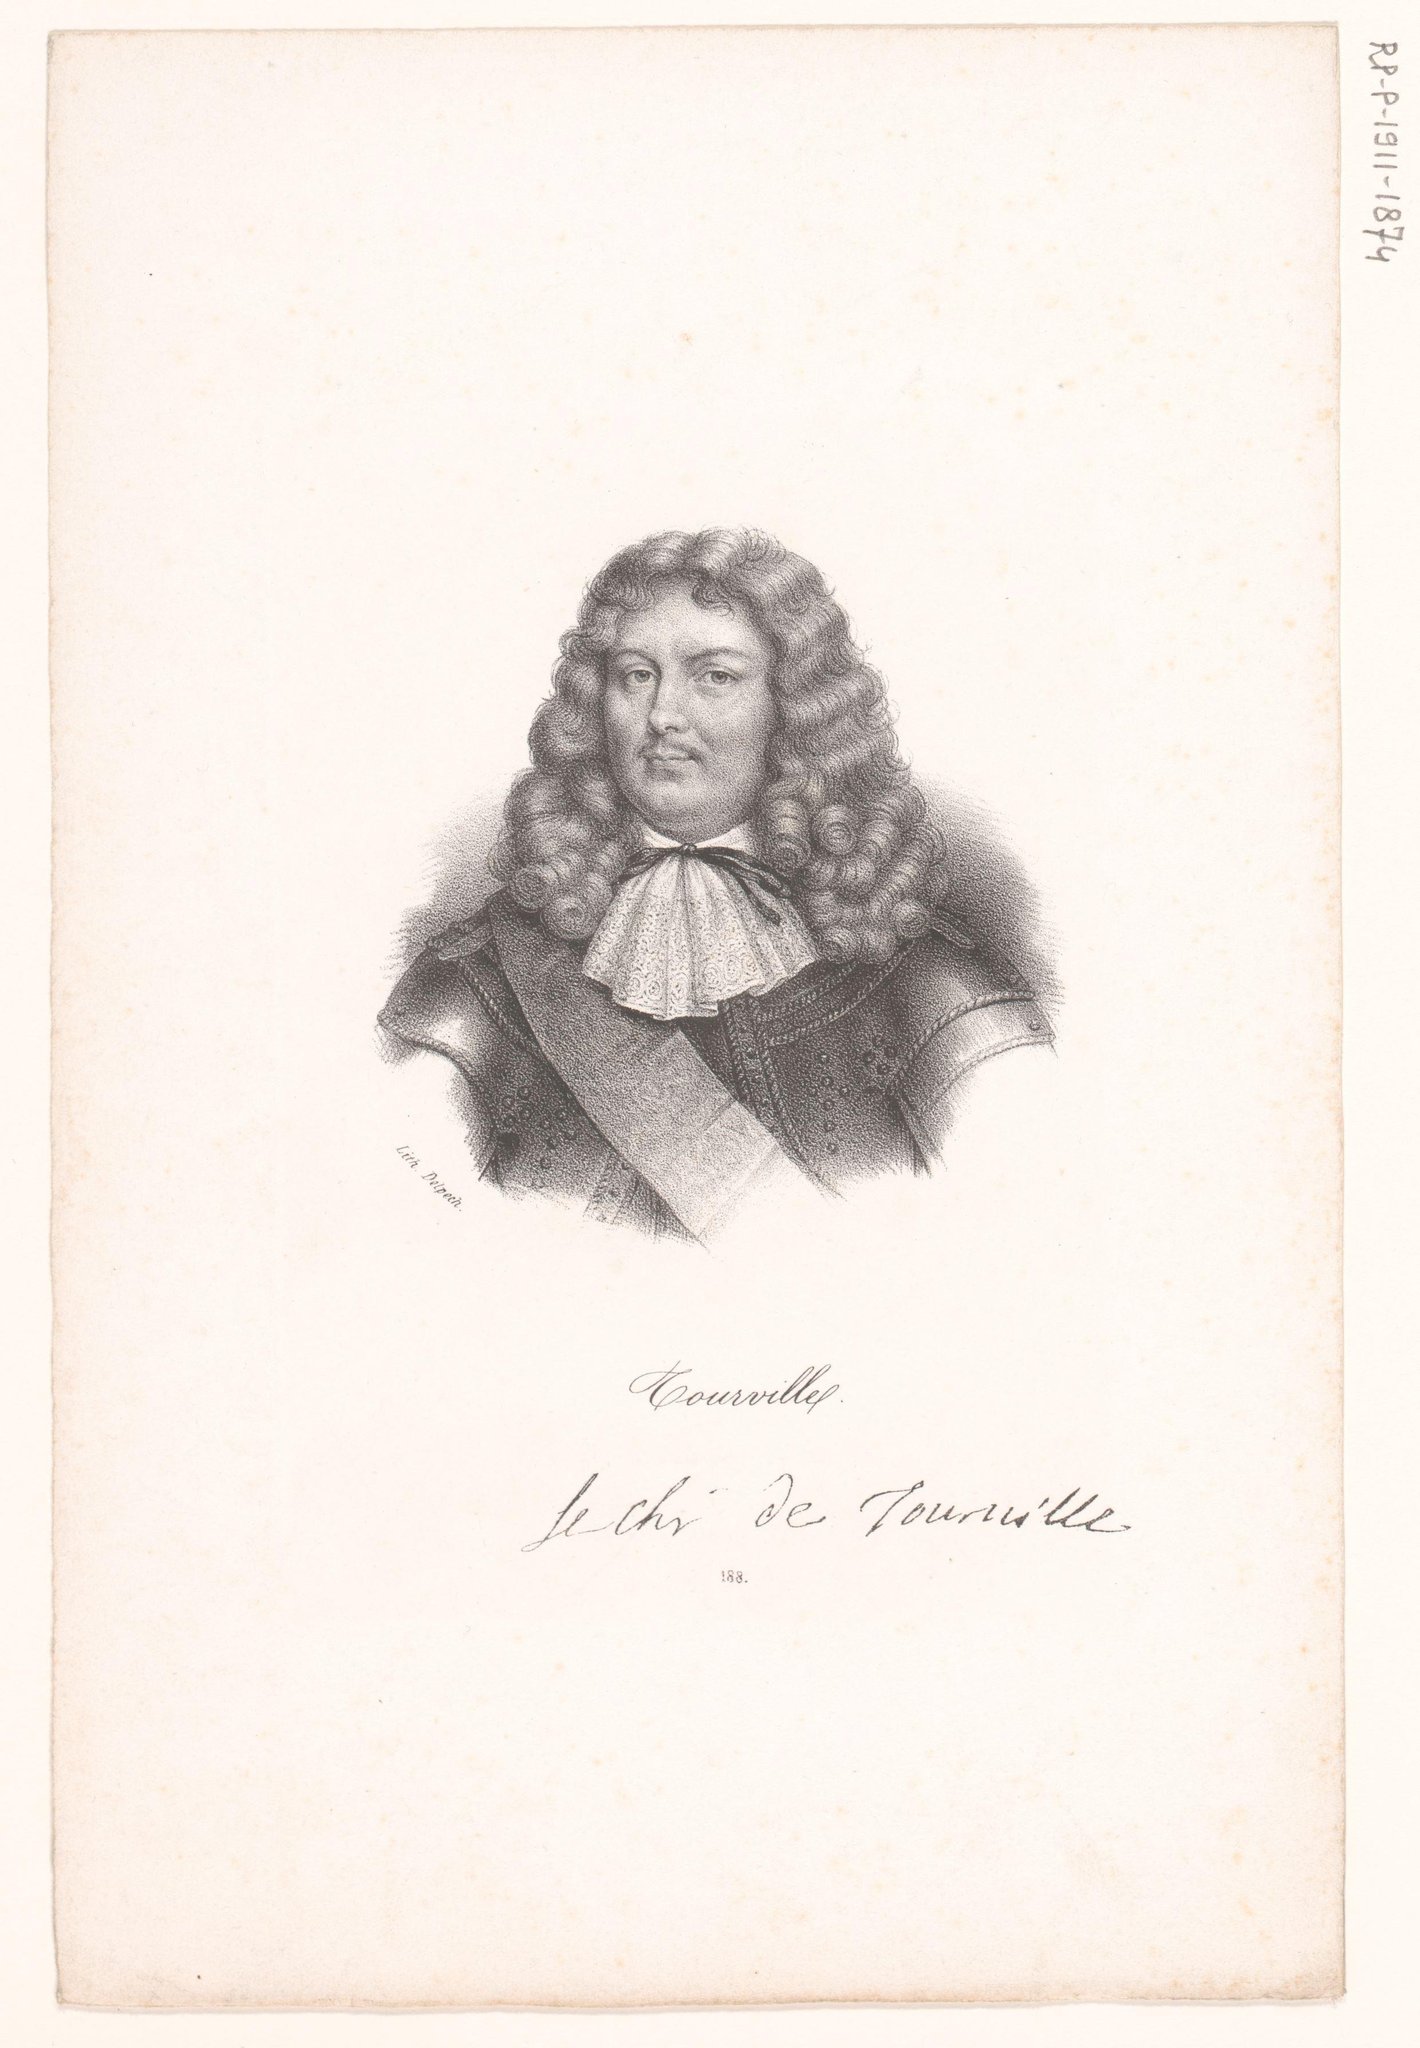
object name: print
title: Portret van Anne-Hilarion de Tourville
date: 1818-1842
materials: paper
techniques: lithograph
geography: paris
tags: paris, historical persons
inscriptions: collector's mark: Lugt 2228a